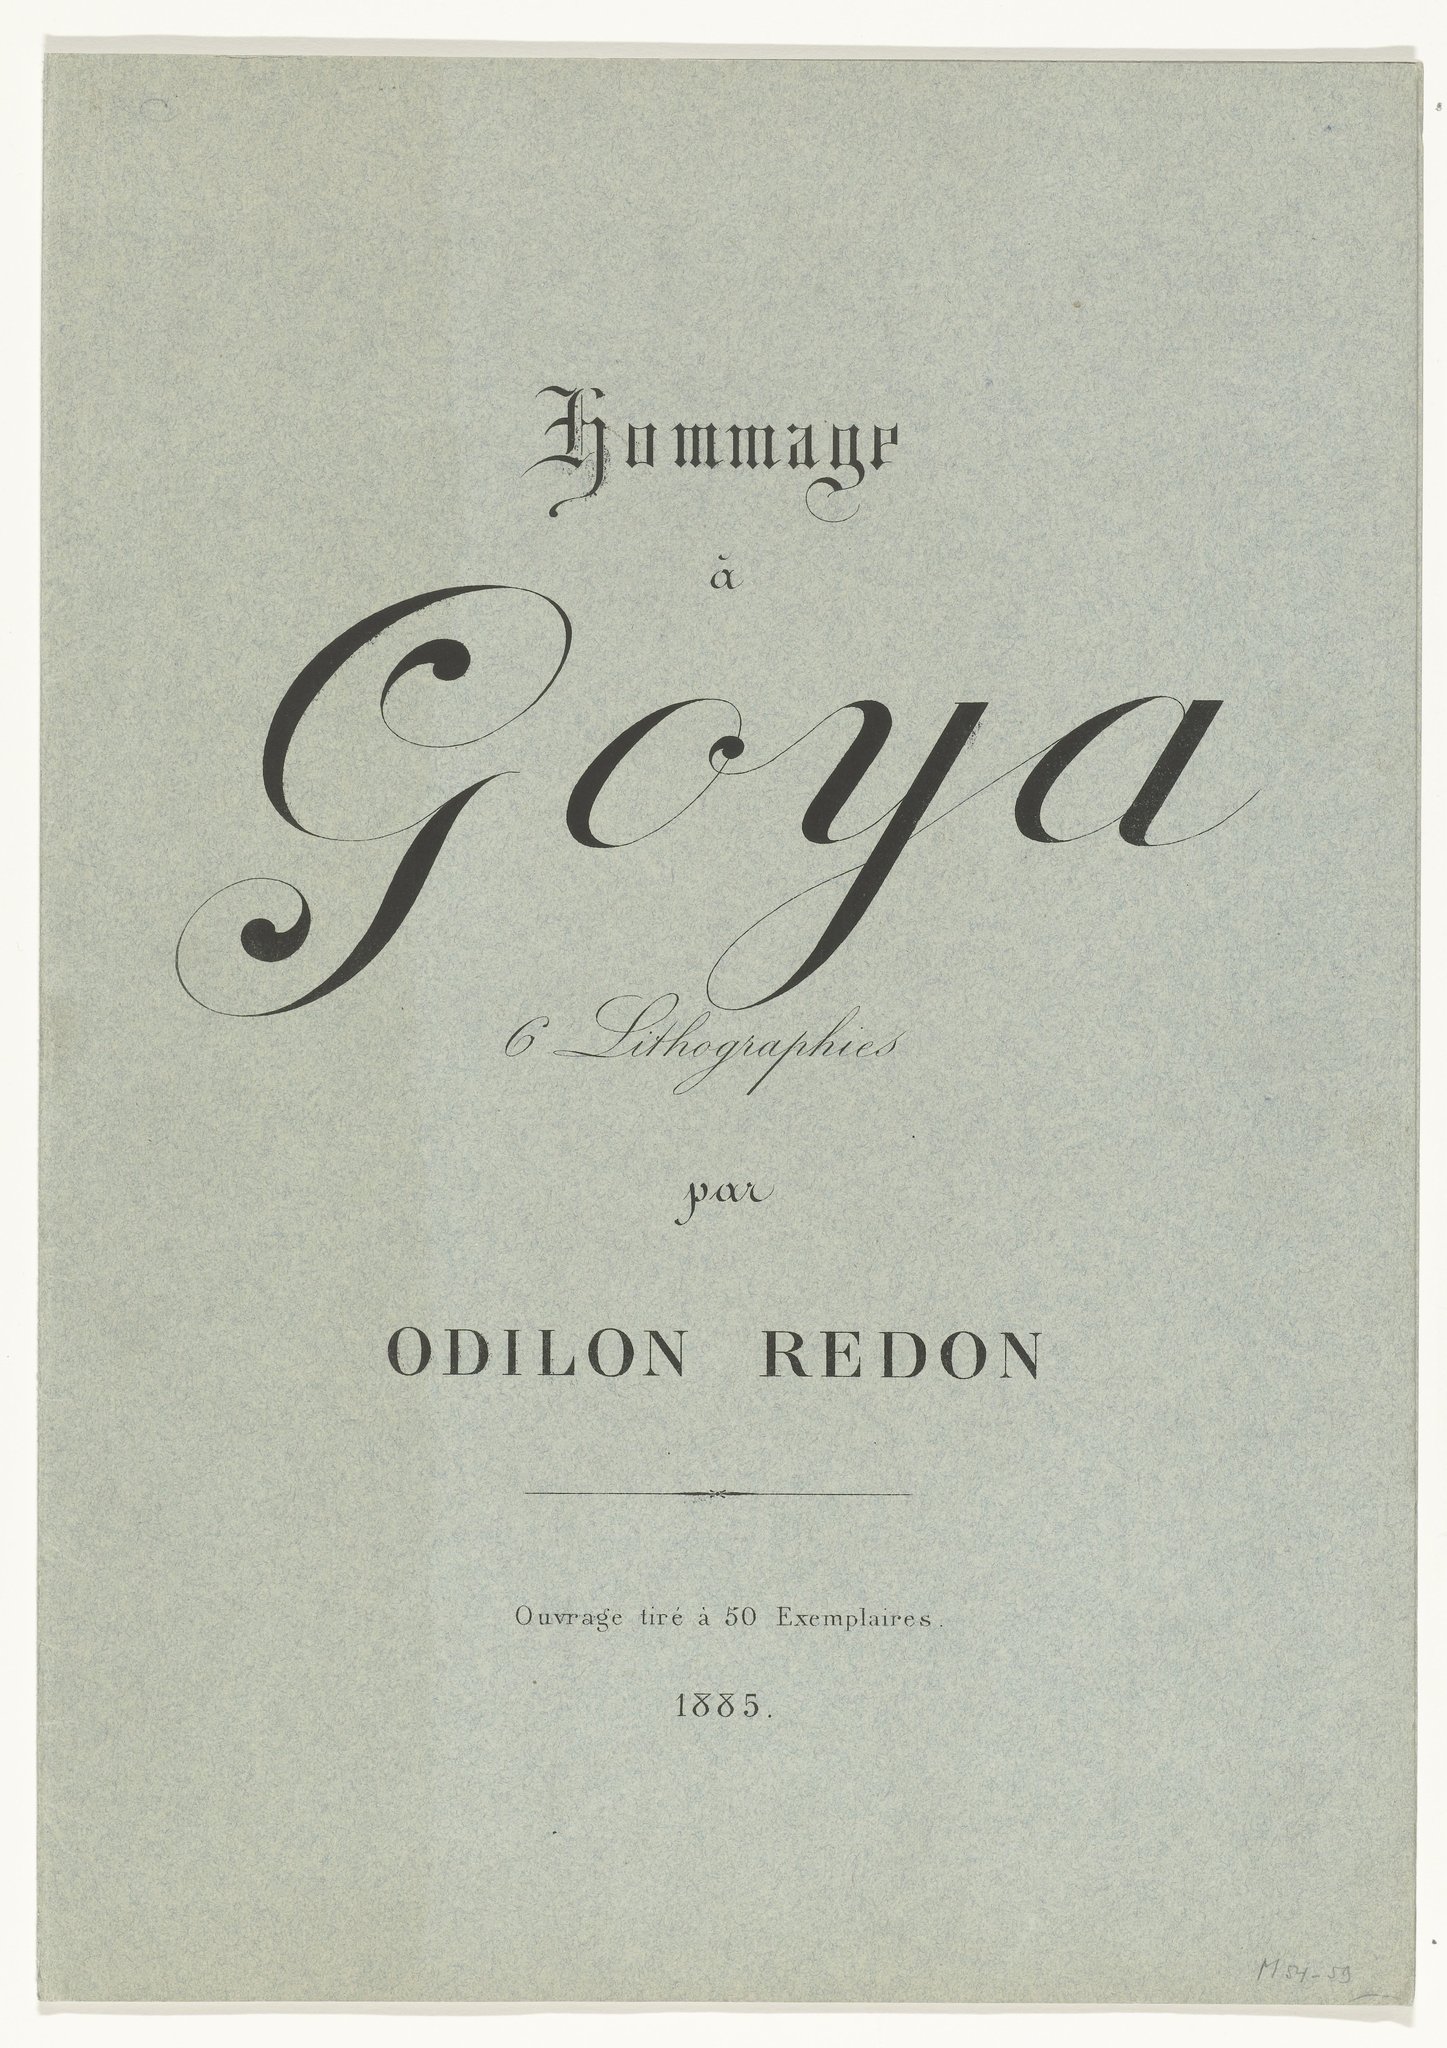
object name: print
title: Hommage à Goya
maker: Anonymous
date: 1885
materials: paper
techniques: lithograph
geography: france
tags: title-page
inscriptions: collector's mark: Lugt 2228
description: Omslag voor een album van zes prenten van Redon.